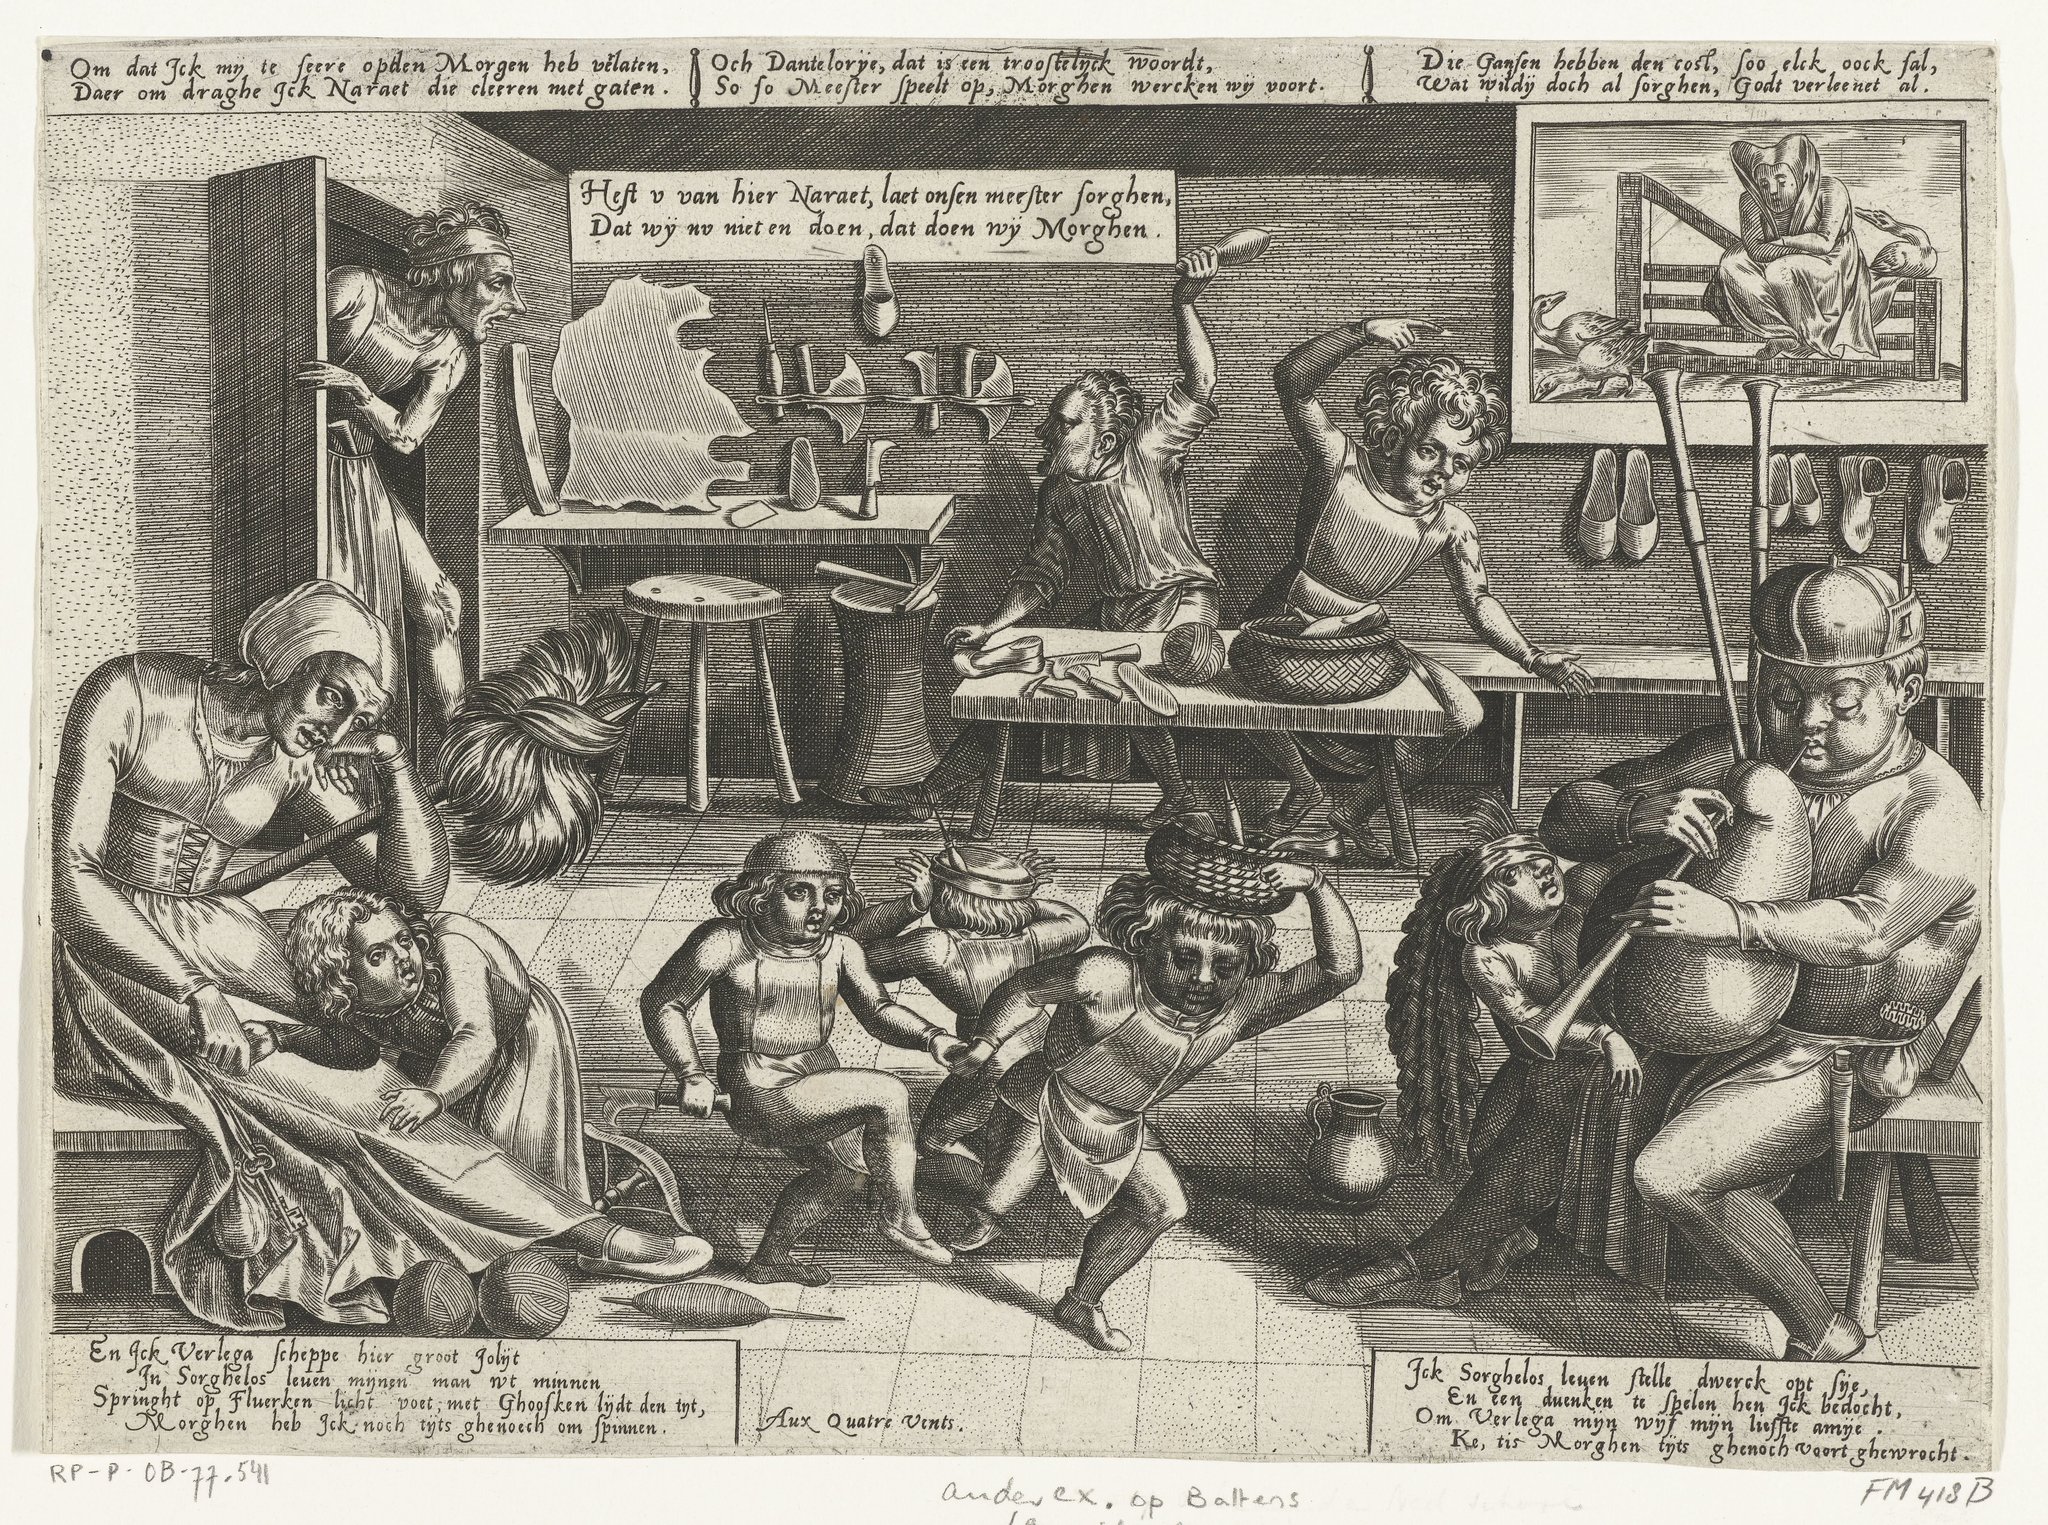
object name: print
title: Sorgheloos leven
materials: paper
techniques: engraving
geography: southern netherlands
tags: sluggishness, inertia; 'dapocaggine', 'pigritia' (ripa) (+ situation or event (especially in genre-painting) with symbolical connotation), bagpipe, musette, sluggishness, inertia; 'dapocaggine', 'pigritia' (ripa), shoe-maker, cobbler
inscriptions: address: ‘Aux quatre Vents’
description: Sorgheloos leven. Zorgenloos leven. Spotprent op de luiheid. In een schoenmakerswerkplaats speelt de schoenmaker doedelzak. Tegenover hem zit zijn vrouw, rustend op haar spinrokken, een kind aan haar schoot. Andere kinderen spelen in het vertrek. Tegen de achterwand twee leerlingen die ook niet werken. Aan de muur een afbeelding van een vrouw die op hek zit met enkele ganzen om haar heen. Met opschrift van 6 regels en onderschrift van 8 regels in het Nederlands.